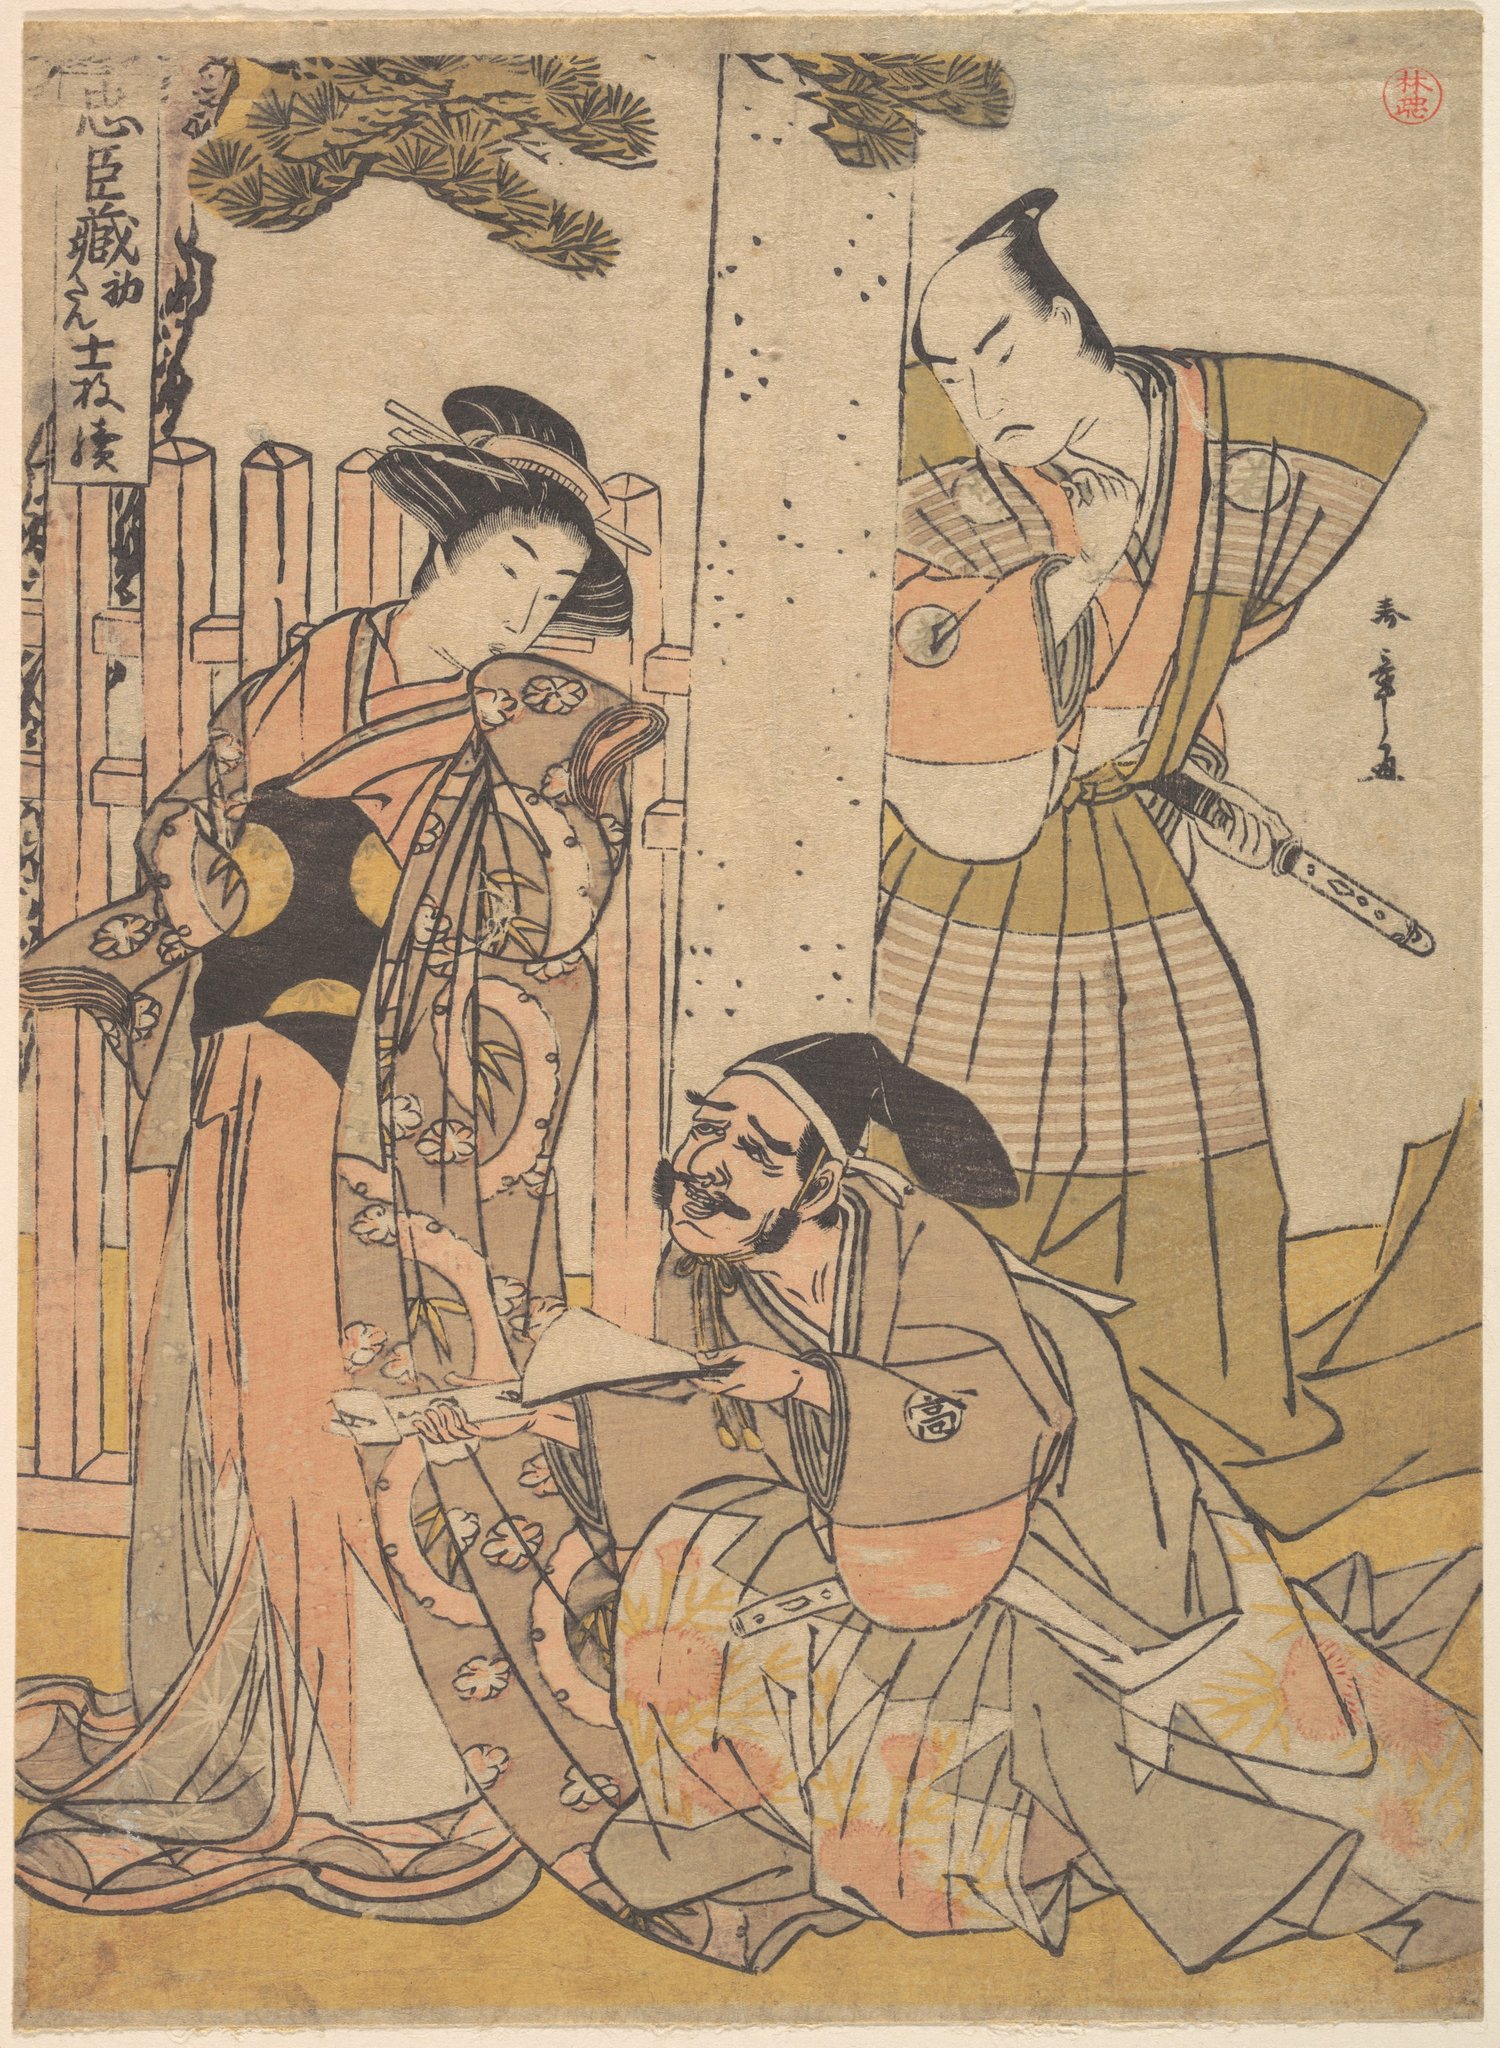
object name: woodblock print nishiki e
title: Chuban of the Chushingura Drama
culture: japanese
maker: katsukawa shunshō 勝川春章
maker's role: artist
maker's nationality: japanese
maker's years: 1726-1792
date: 1615-1868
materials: ink, paper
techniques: nishiki e, woodblock print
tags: men,women